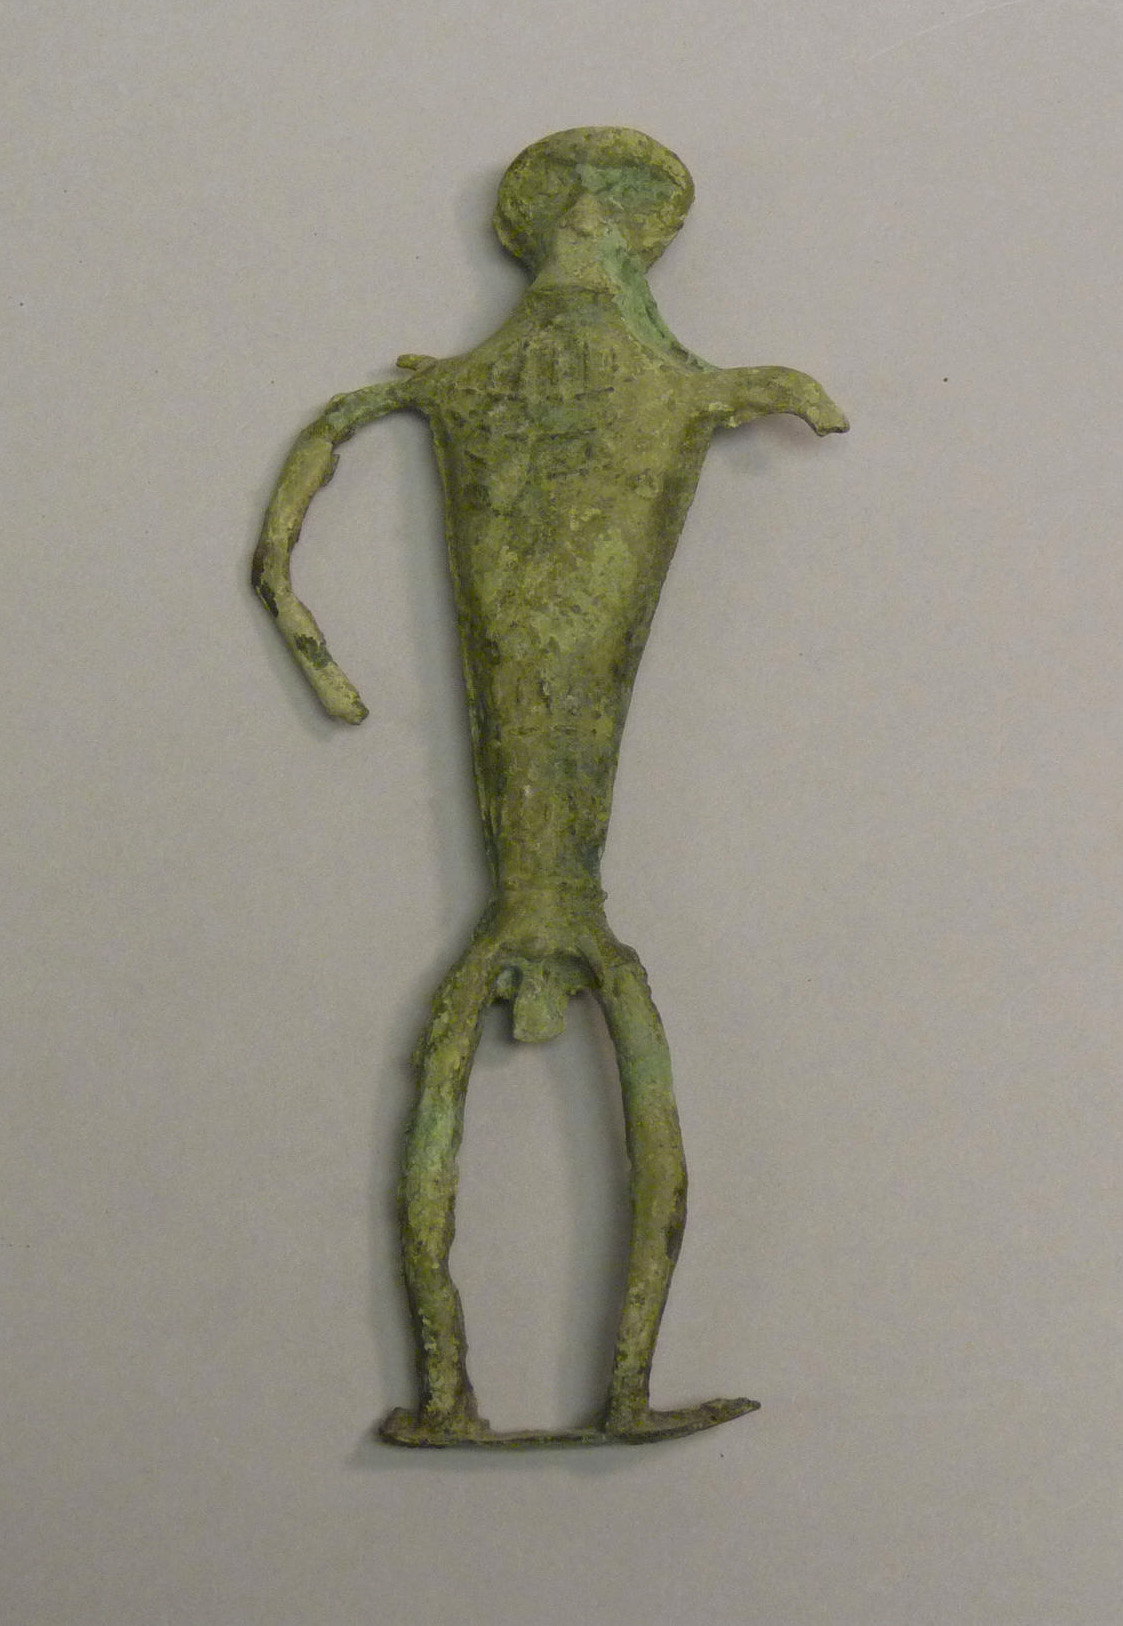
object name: figure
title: Standing Male Figure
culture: indonesian, javanese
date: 500 BCE-300 CE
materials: bronze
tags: men